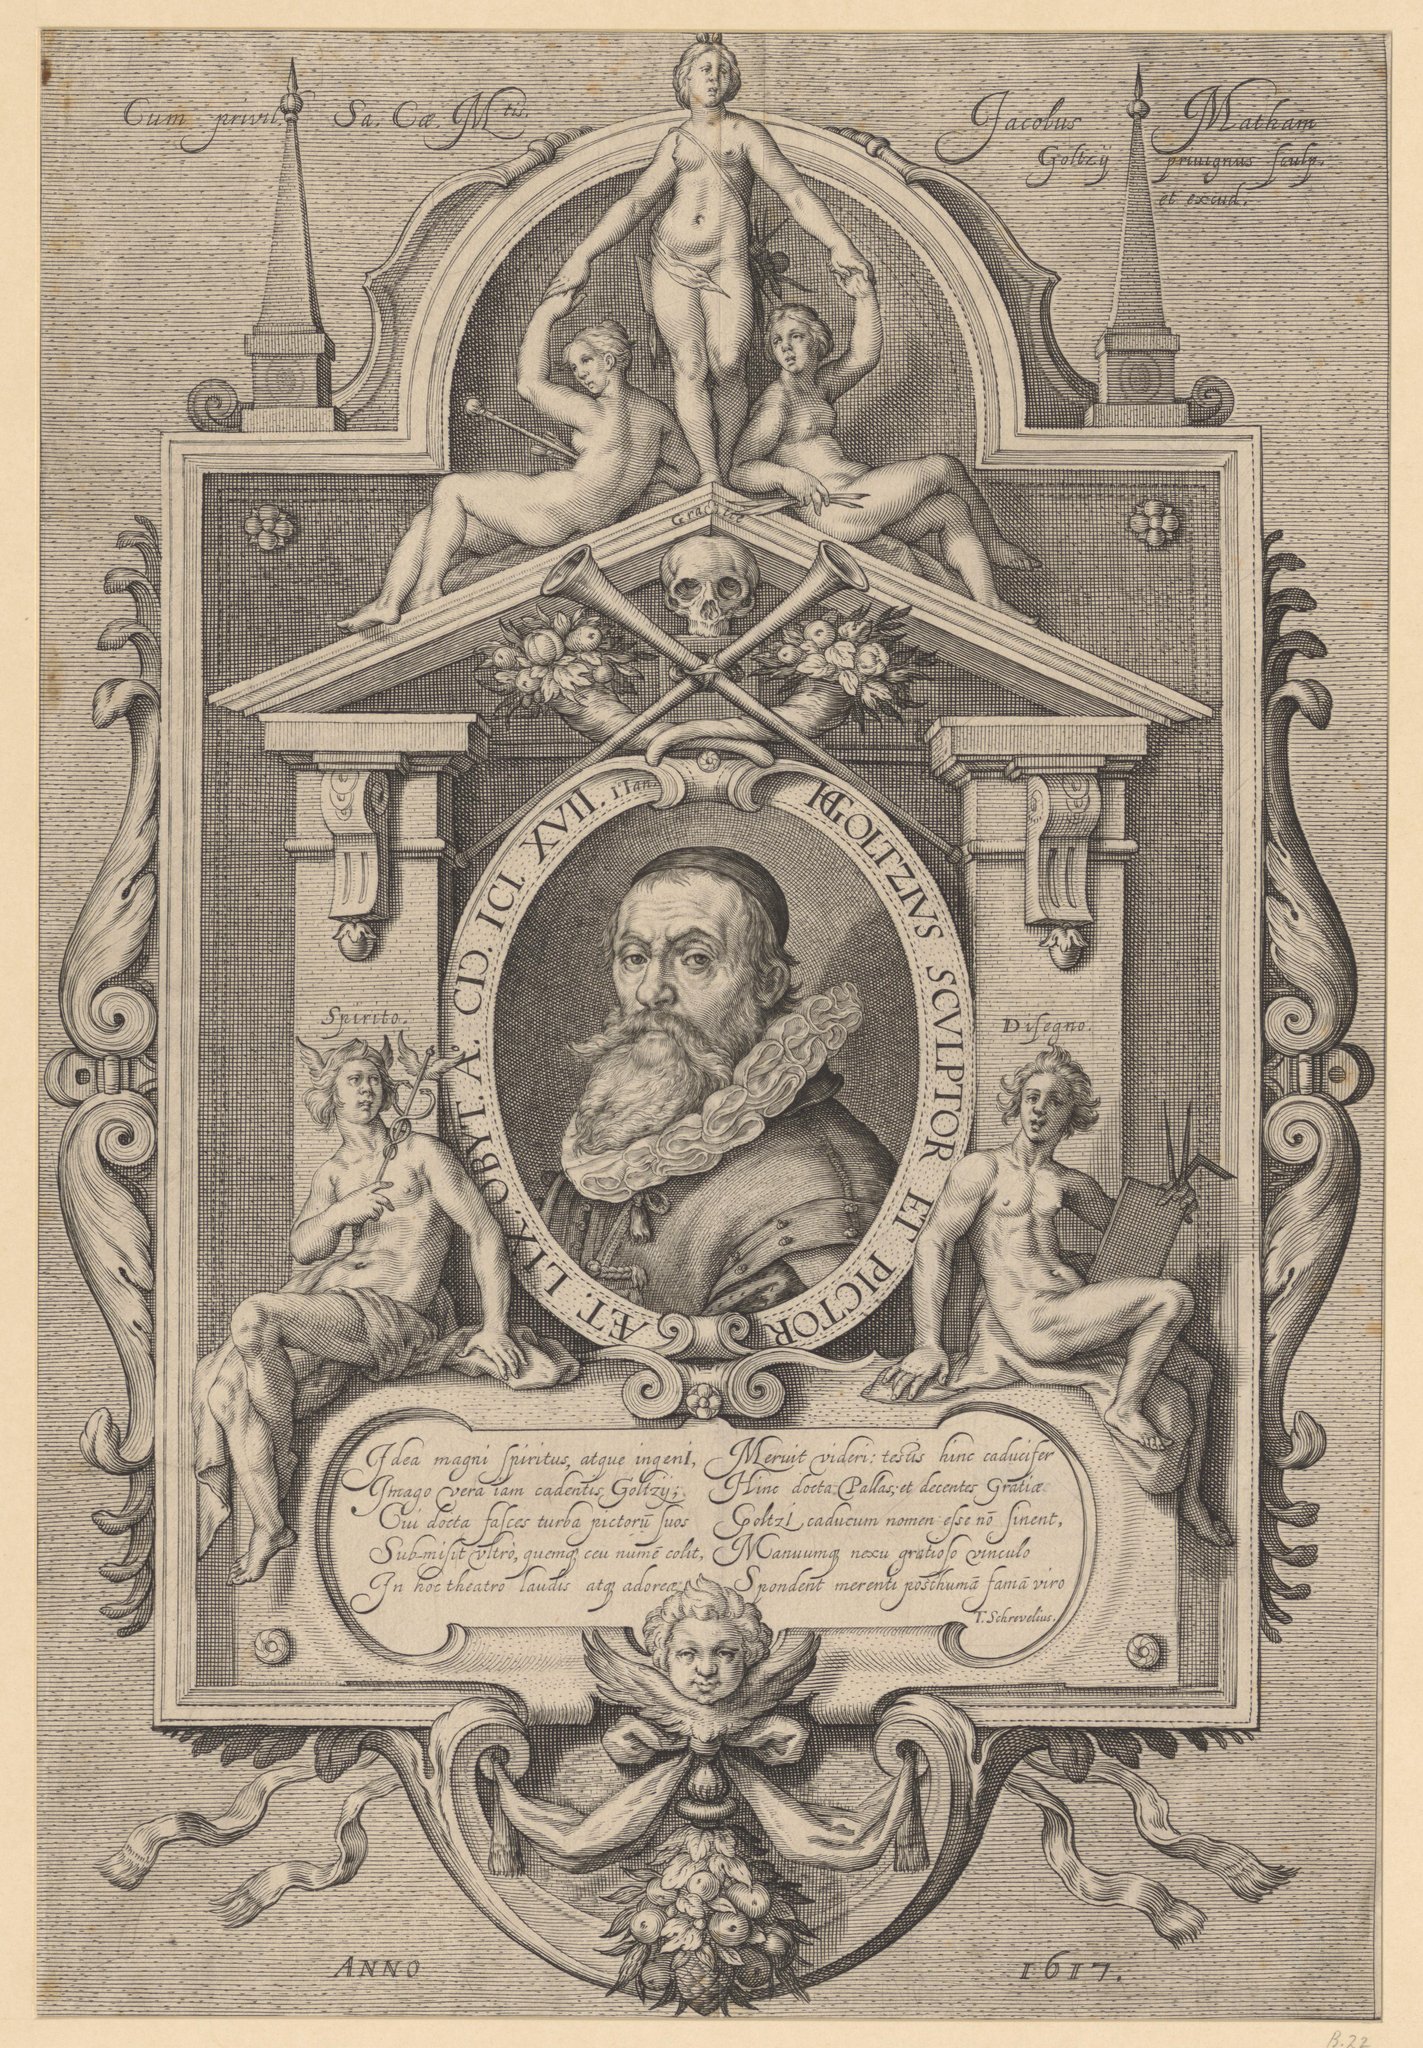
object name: print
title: Portret van Hendrick Goltzius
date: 1617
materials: paper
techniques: engraving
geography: haarlem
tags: haarlem, painter, print maker, draughtsman, hendrick goltzius, 'beatitudine prima', 'povertà di spirito' (ripa), historical persons, graces (charites), generally three in number; 'gratie' (ripa), portrait, self-portrait of painter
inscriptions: collector's mark: Lugt 963, collector's mark: Lugt 2228